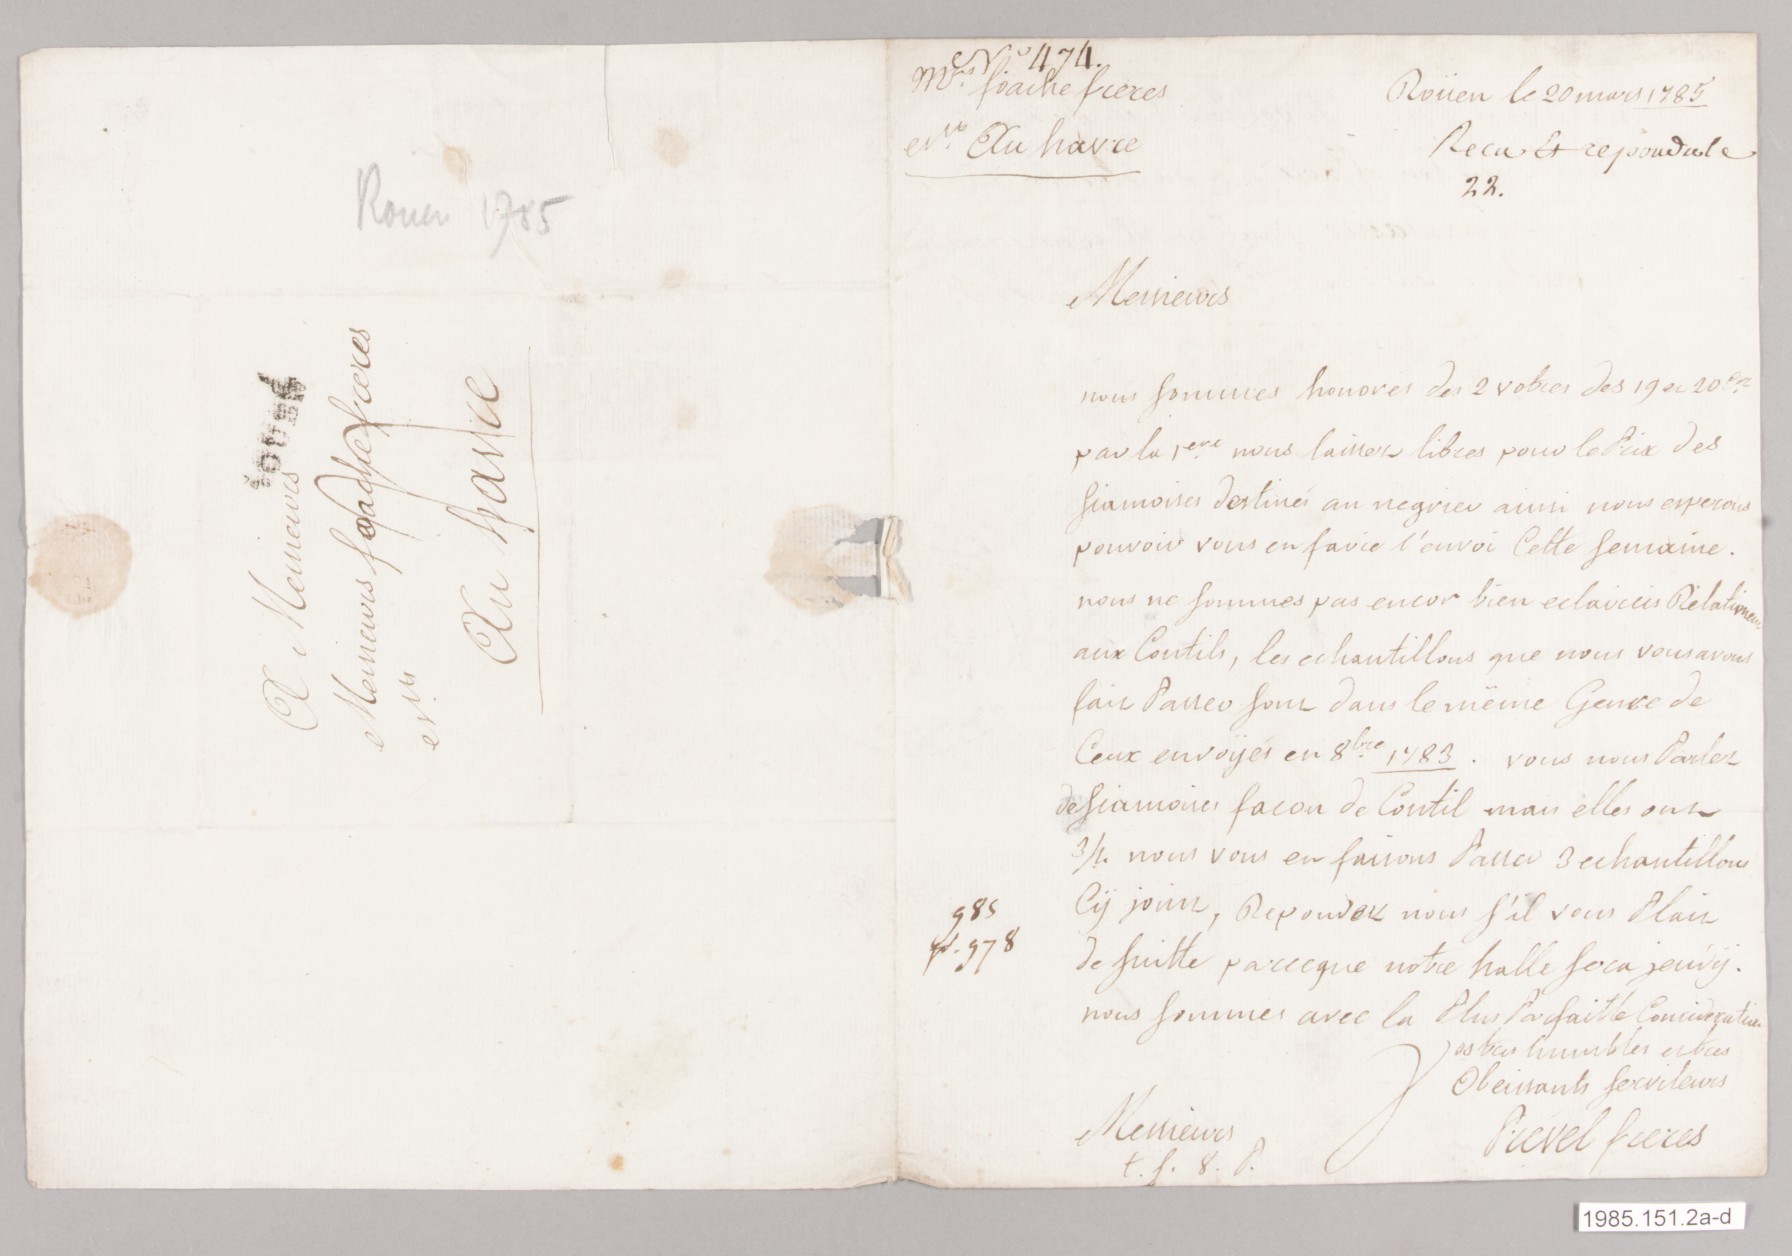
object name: letter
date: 1767-1800